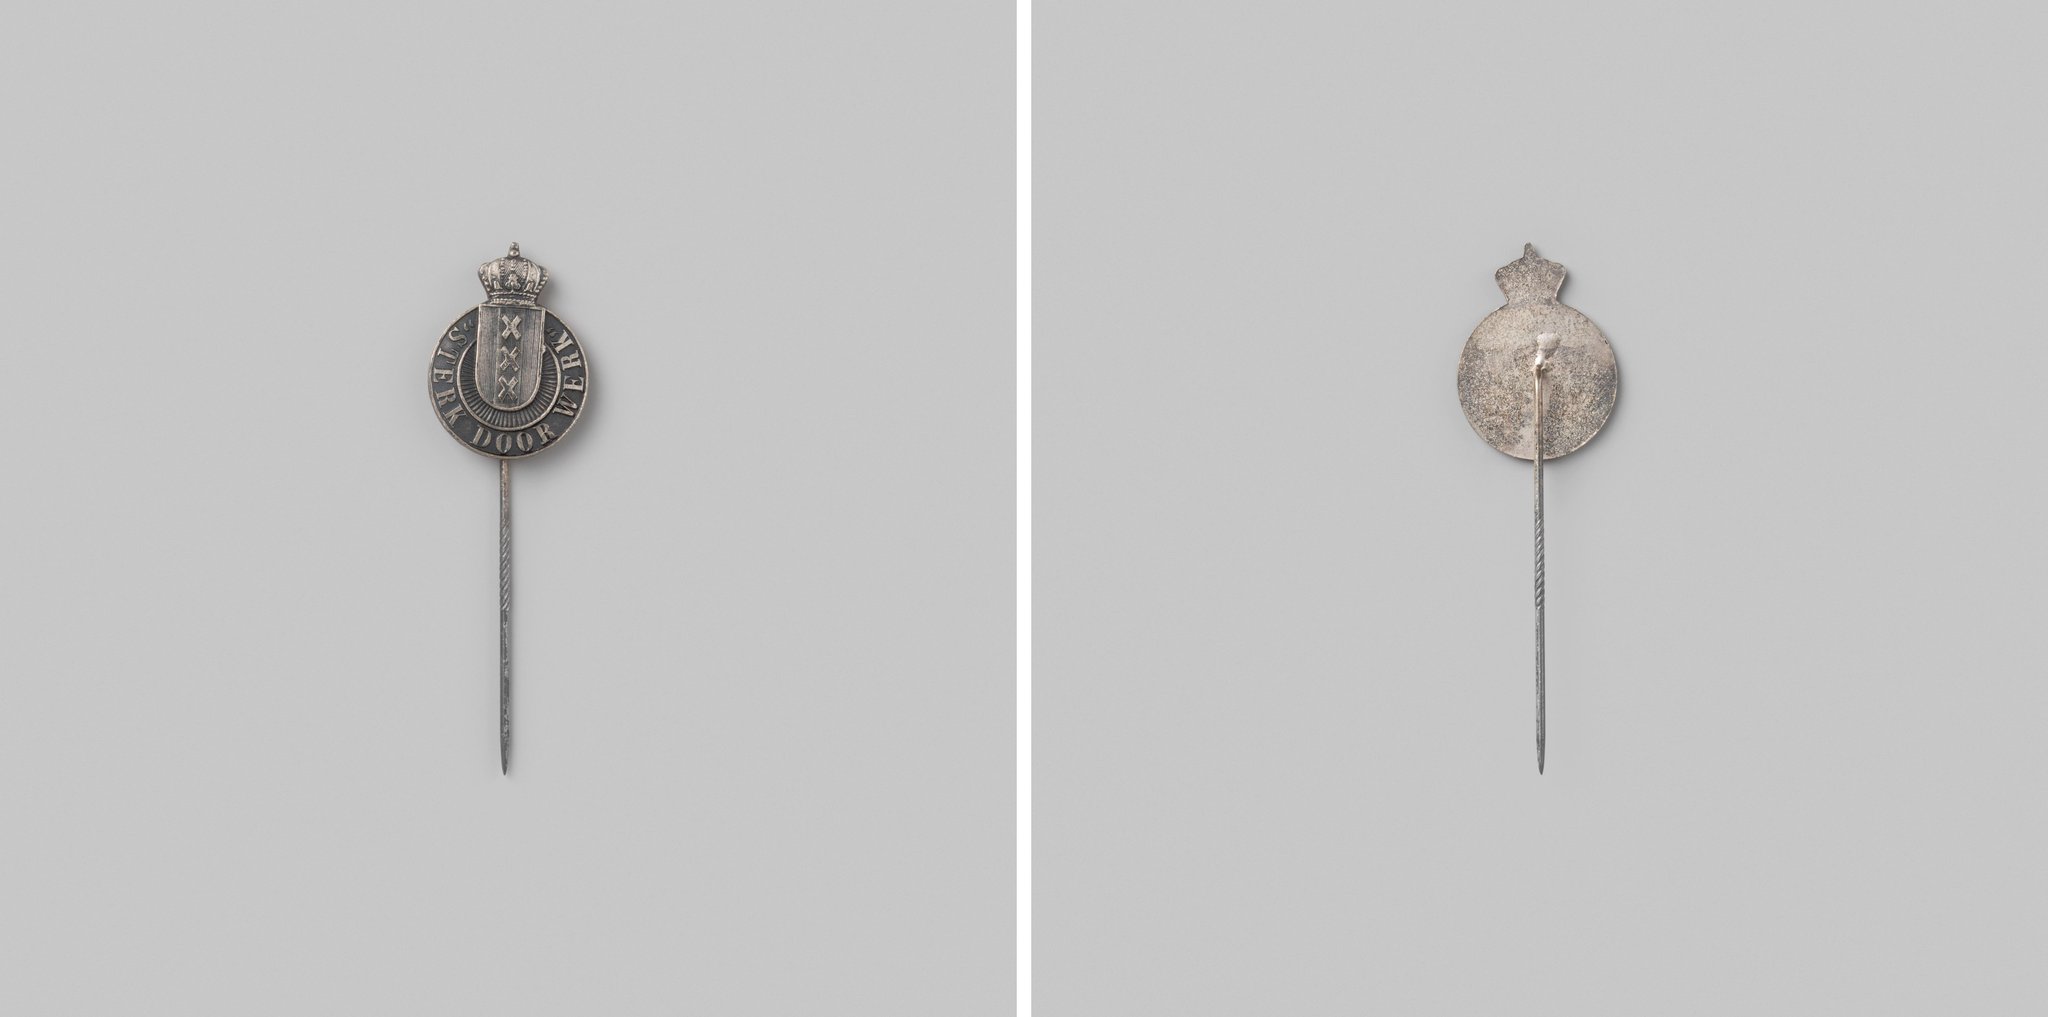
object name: plaque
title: Sterk door Werk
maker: Anonymous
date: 1900-1950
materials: alloy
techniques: striking, welding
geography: amsterdam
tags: amsterdam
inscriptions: inscription: ‘STERK DOOR WERK’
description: Eenzijdige plaquette, rond met kroon, op speld, waarvan deel is versierd met gegroefde, gedraaide versiering. Voorzijde: gekroond wapenschild van Amsterdam binnen omschrift. Keerzijde: blanco.